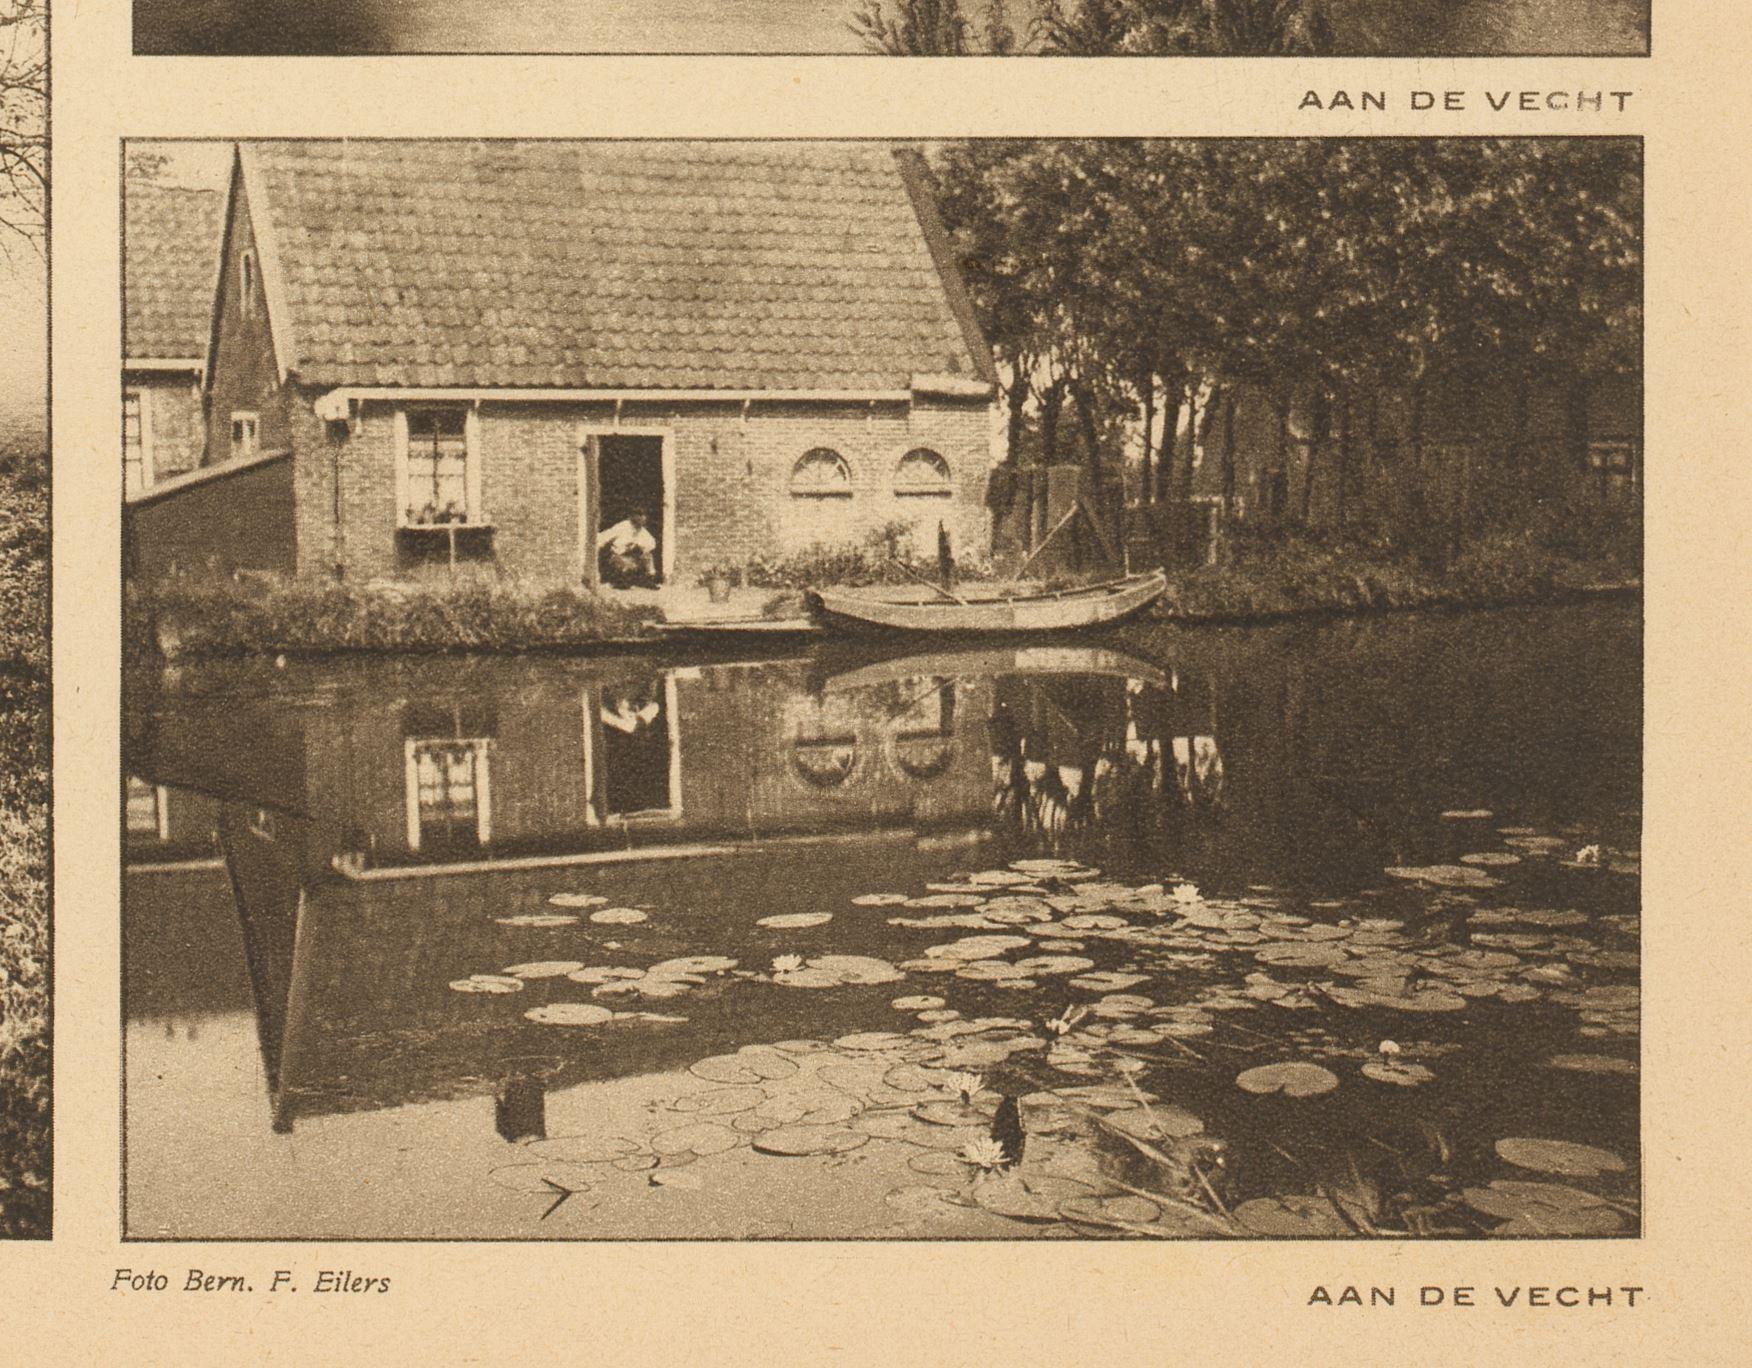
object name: photomechanical print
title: Aan de vecht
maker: bernard eilers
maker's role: fotograaf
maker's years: 1878-1951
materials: paper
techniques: rotogravure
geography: leiden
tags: rural housing, e.g. country-house, villa, cottage, canals, waters (in village), rowing-boat, canoe, etc., vecht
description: Deze prent maakt deel uit van een album.